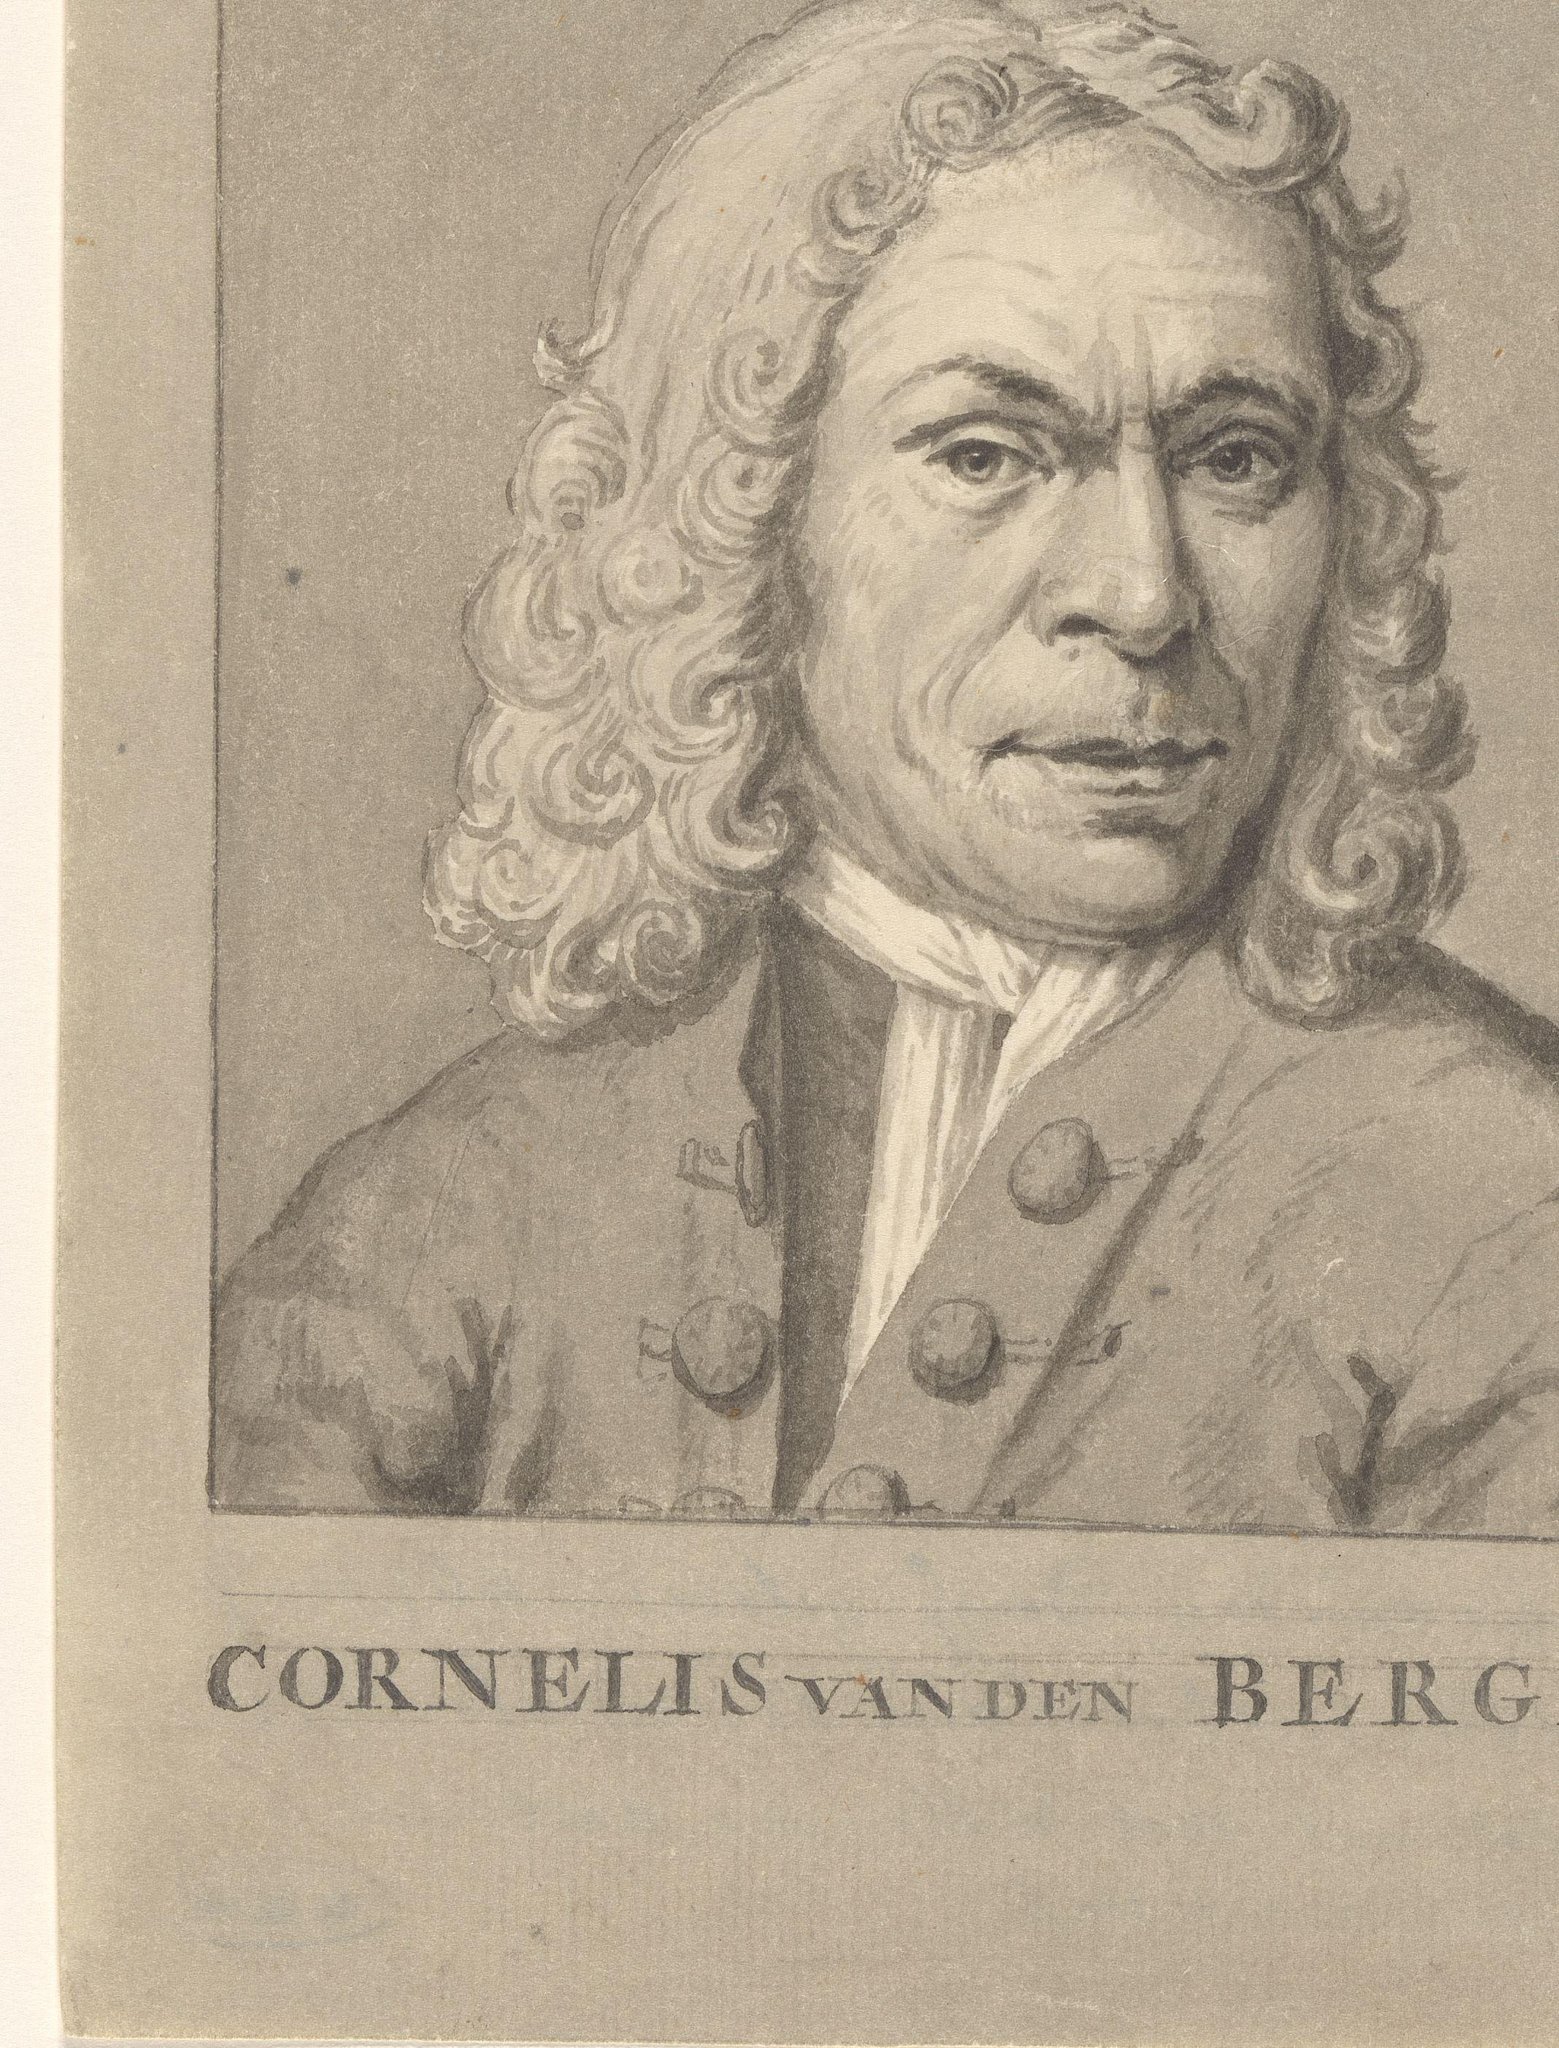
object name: drawing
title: Portret van Cornelis van den Berg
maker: Anonymous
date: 1725-1775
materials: pencil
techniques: brush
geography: netherlands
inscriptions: inscription: ‘Cornelis van den Bergh, gebooren 1667 den 7 - / augusti, overleeden den 13 December 1744 - / was getrouwt met Willimina Malbertsz - / den 16 maart 1698.’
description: Onderschrift 'Cornelis van den Bergh'; op de achterzijde biografische gegevens in contemporain handschrift.